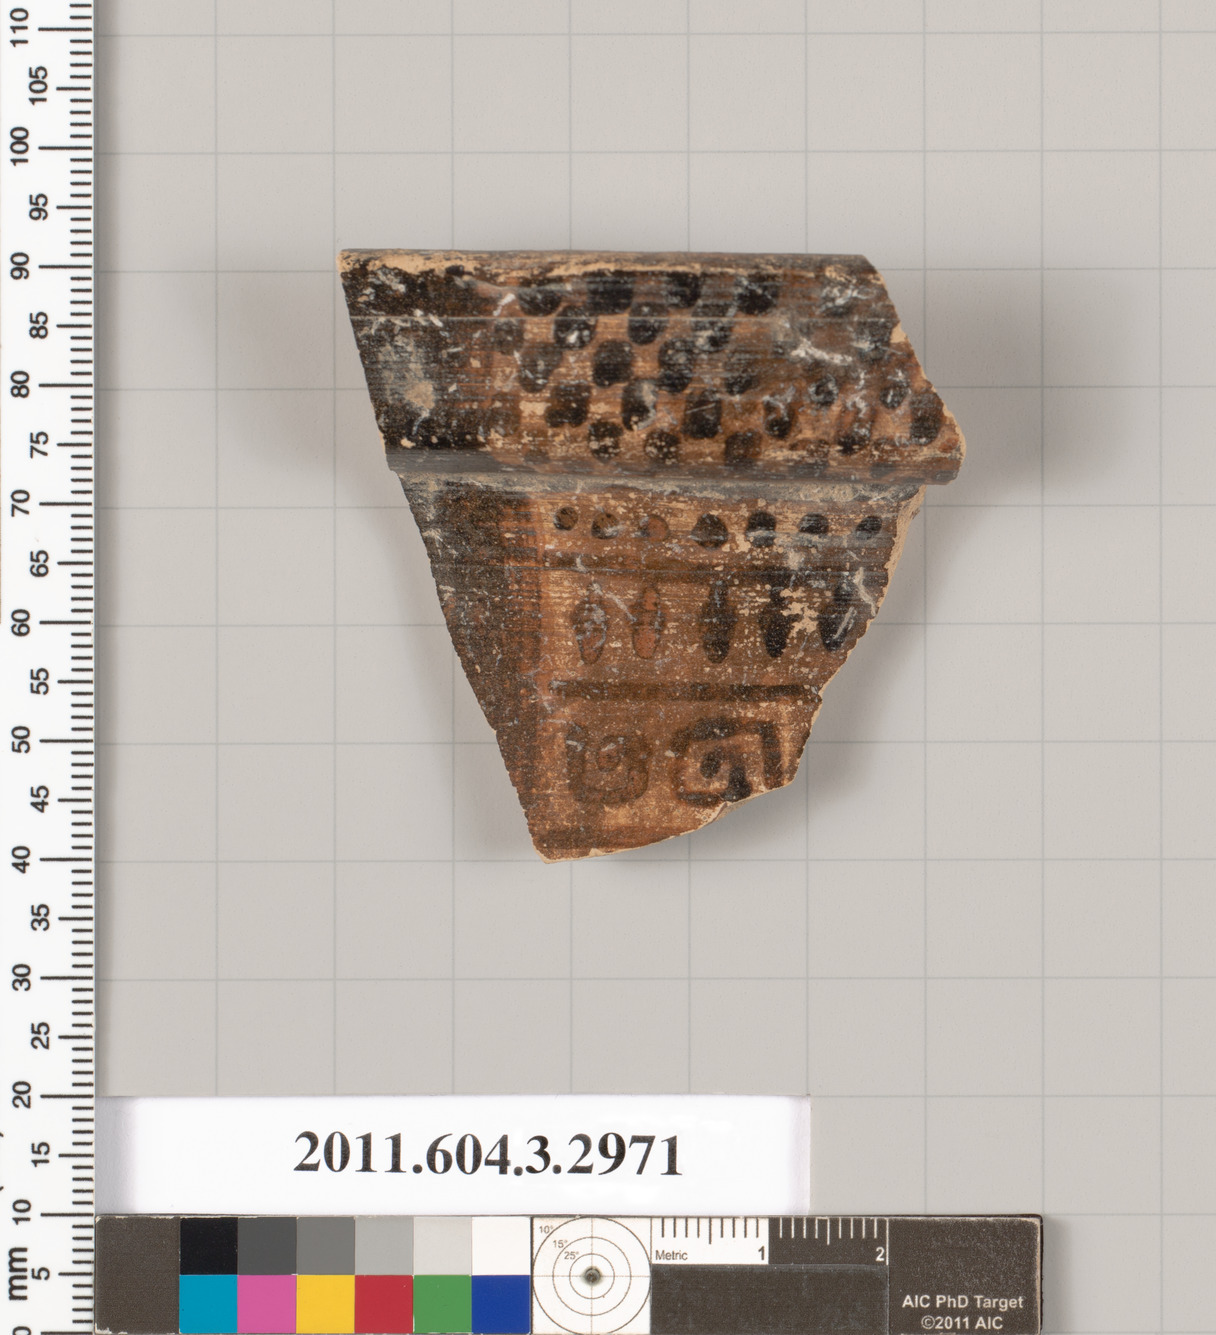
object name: olpe fragment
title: Terracotta fragment of an olpe (jug)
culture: greek, attic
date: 530-520 BCE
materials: terracotta